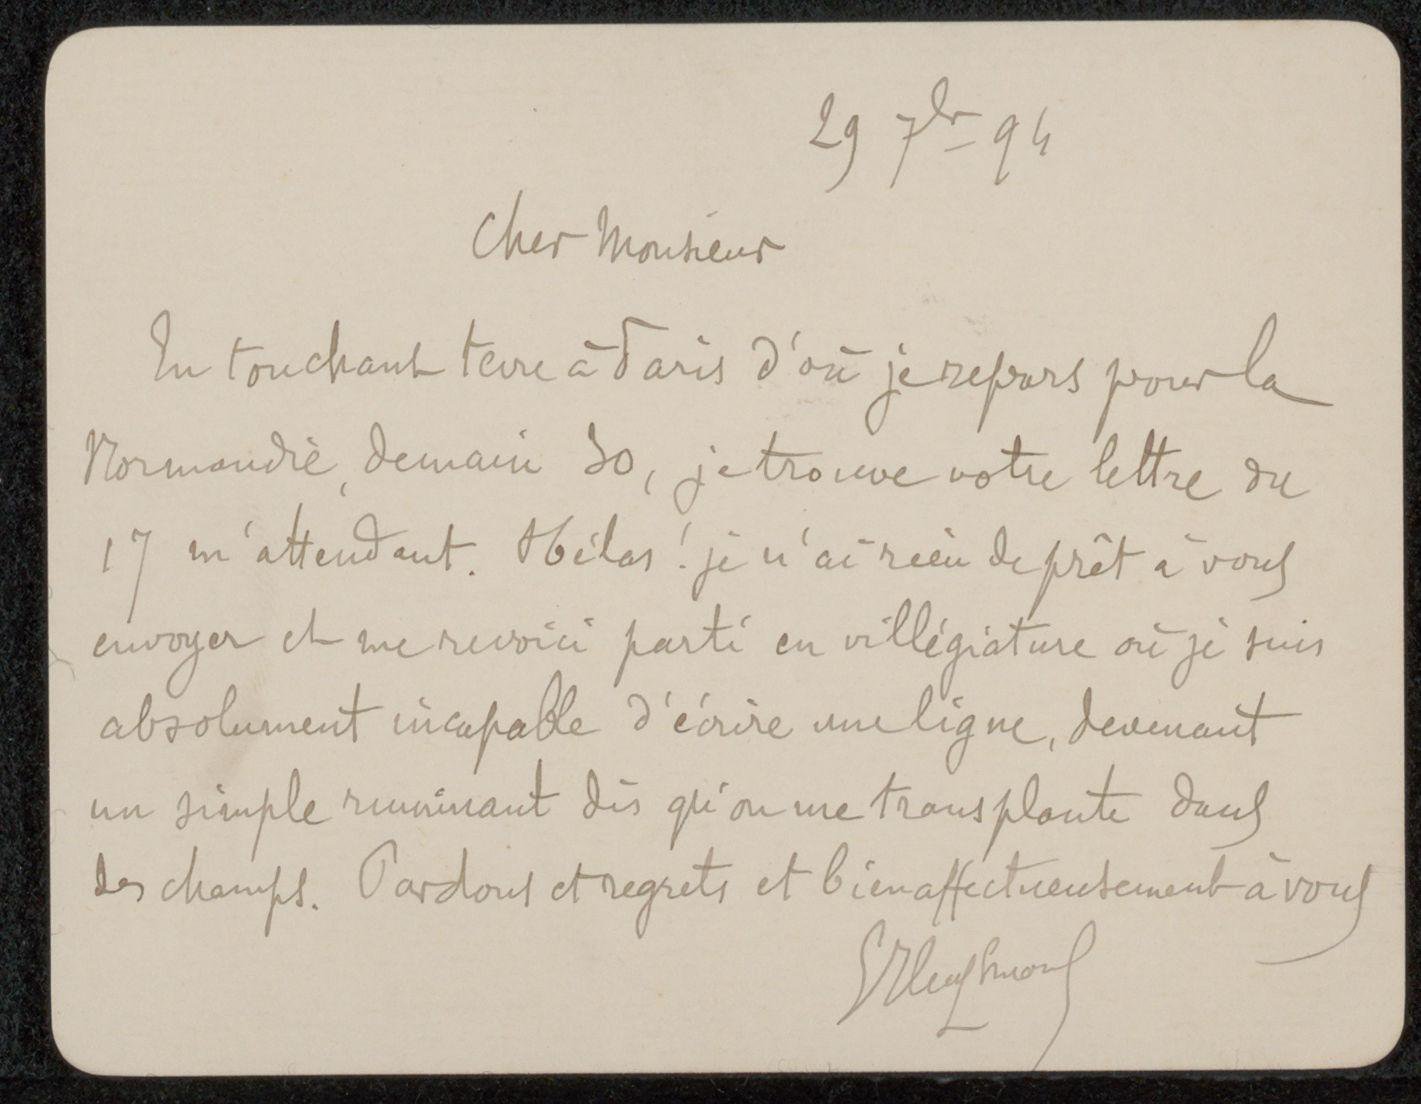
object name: letter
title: Brief aan Philip Zilcken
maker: joris-karl huysmans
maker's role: schrijver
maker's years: 1848-1907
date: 1894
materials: cardboard, ink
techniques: pen, writing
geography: paris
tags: painter, draughtsman, philip zilcken, paris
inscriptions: collector's mark: ‘RPK’